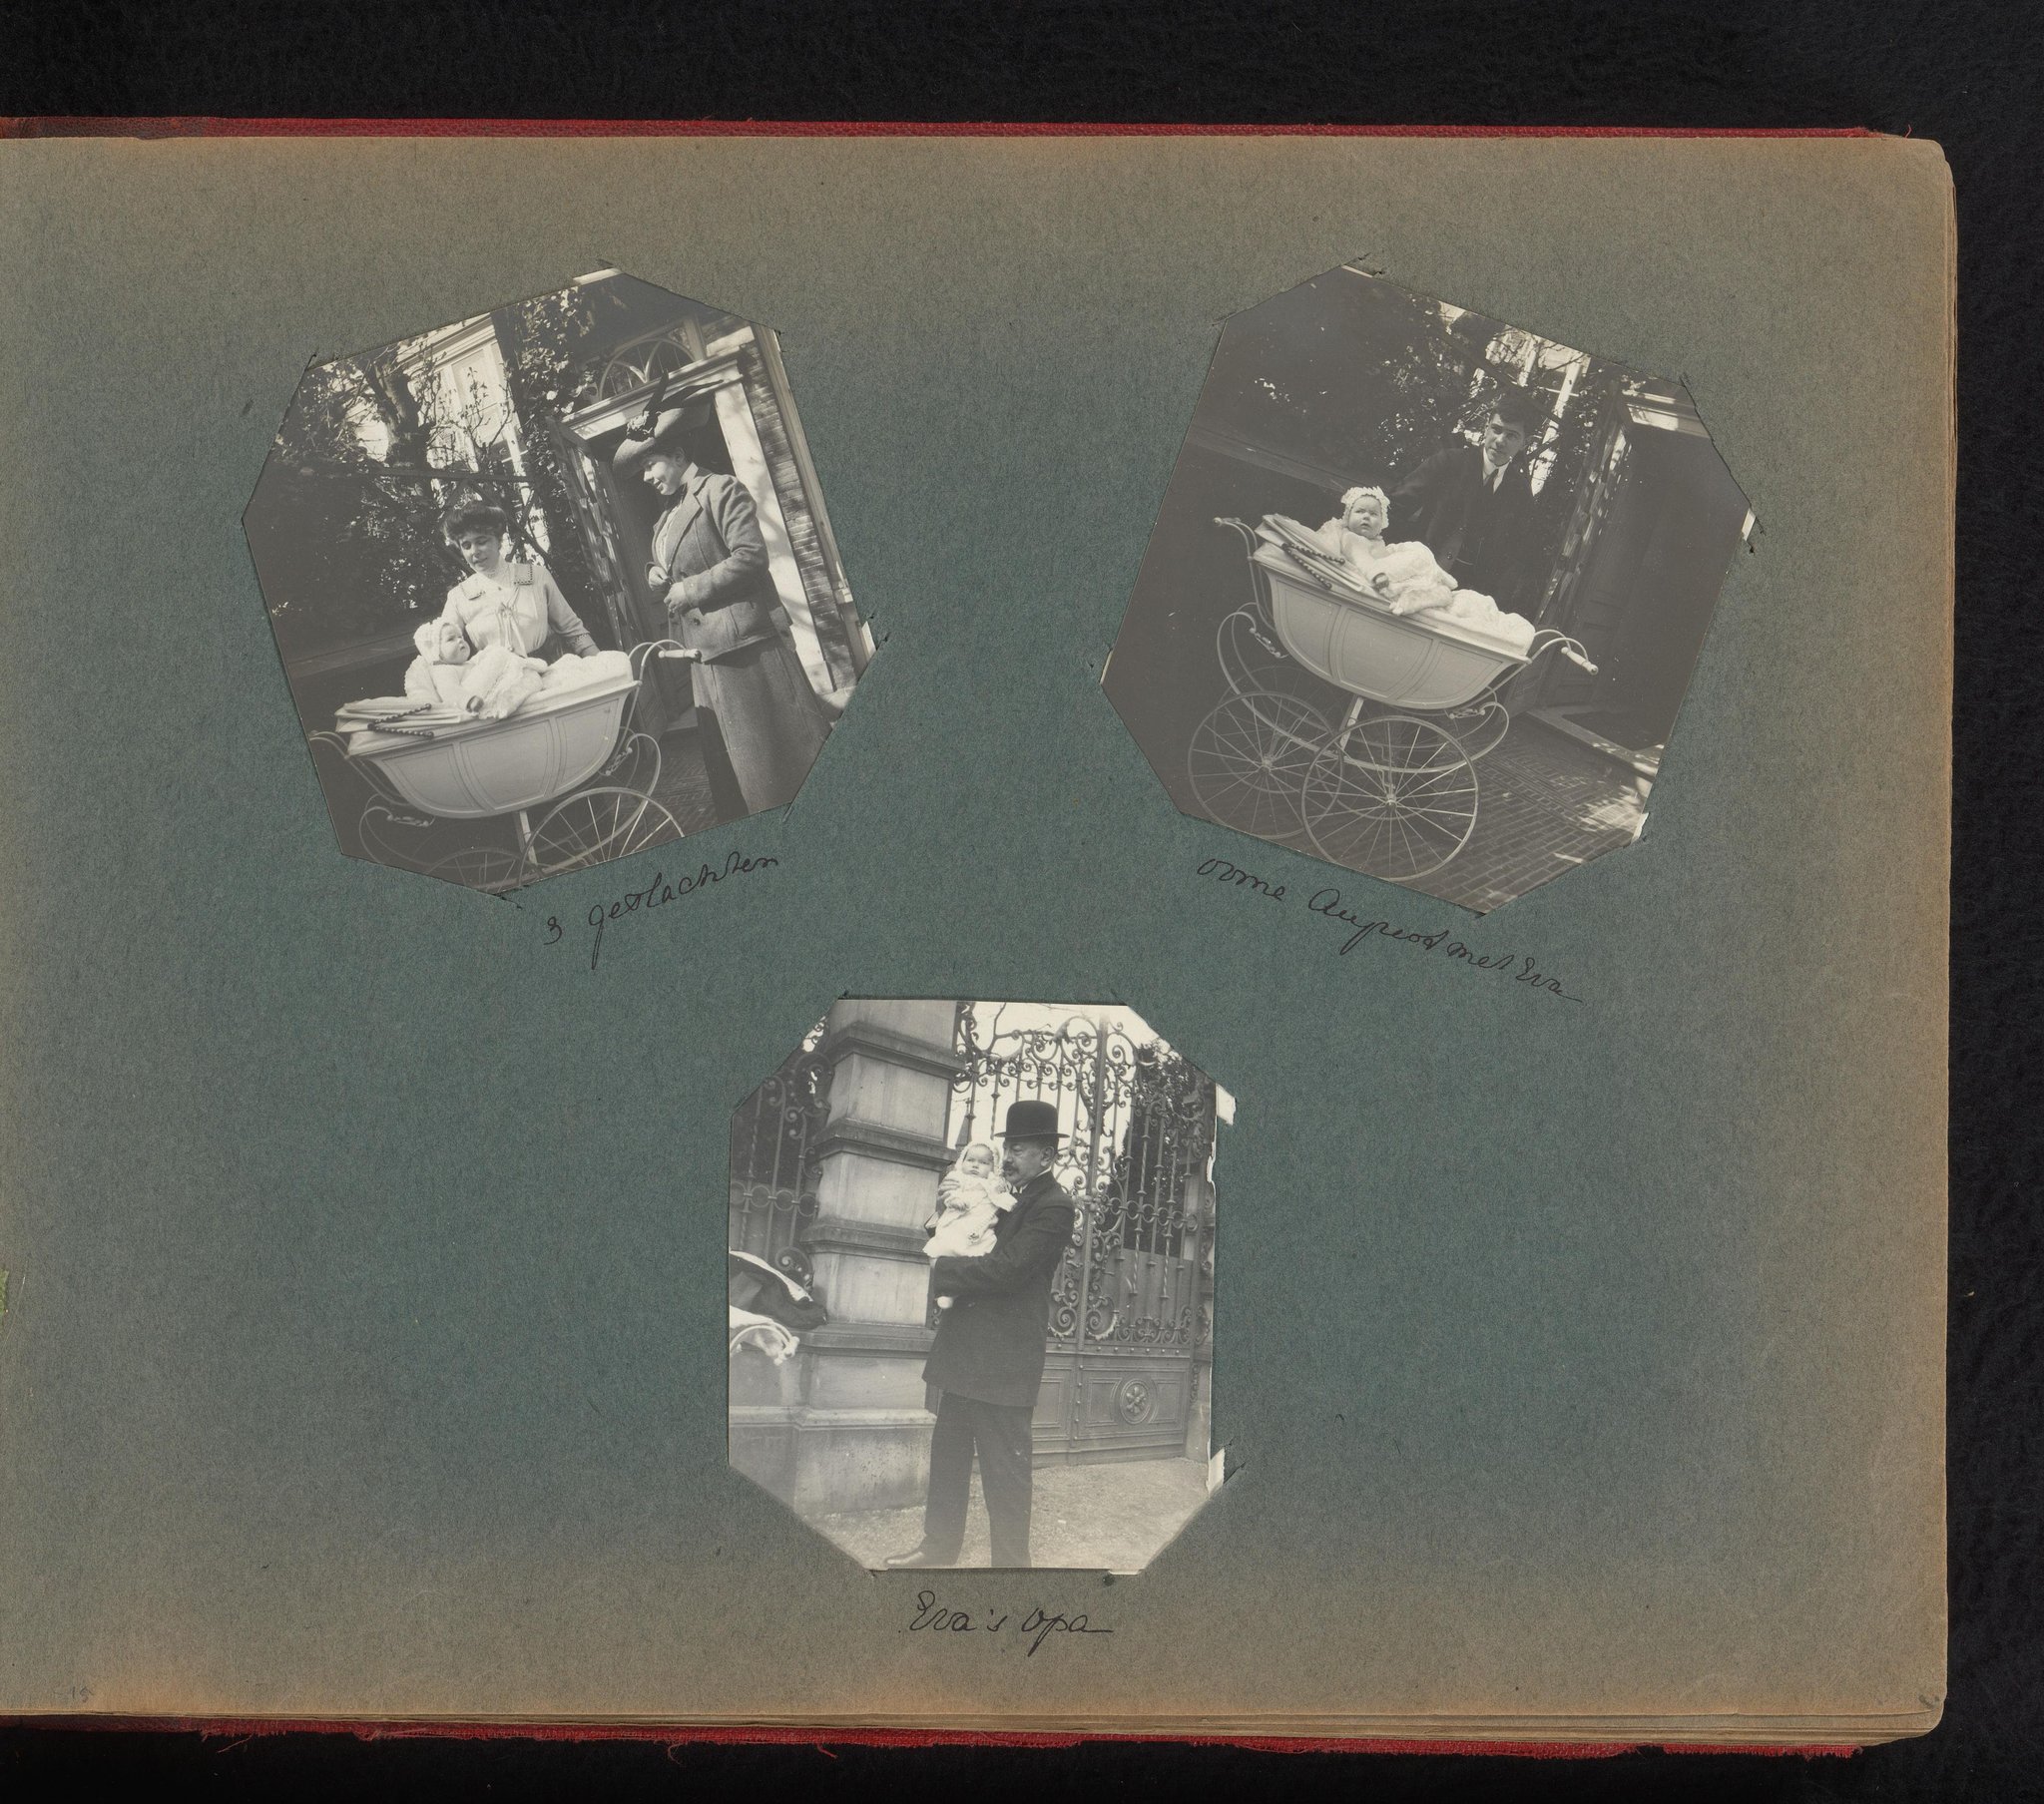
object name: photograph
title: Drie taferelen met familieleden van Eva Boelen, waaronder Charlotte Boelen-Matthes, August Matthes, Hendrik Matthes en Charlotte Matthes-Doorman, rond haar kinderwagen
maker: charlotte alida boelen-matthes (lot)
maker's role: amateurfotograaf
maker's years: 1889-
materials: paper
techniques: gelatin silver print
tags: amsterdam, thailand, eva charlotte pennink-boelen, charlotte alida boelen-matthes (lot), baby-carriage, pram, perambulator, child(ren) with other members of the family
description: Deze foto's zijn onderdeel van een album.